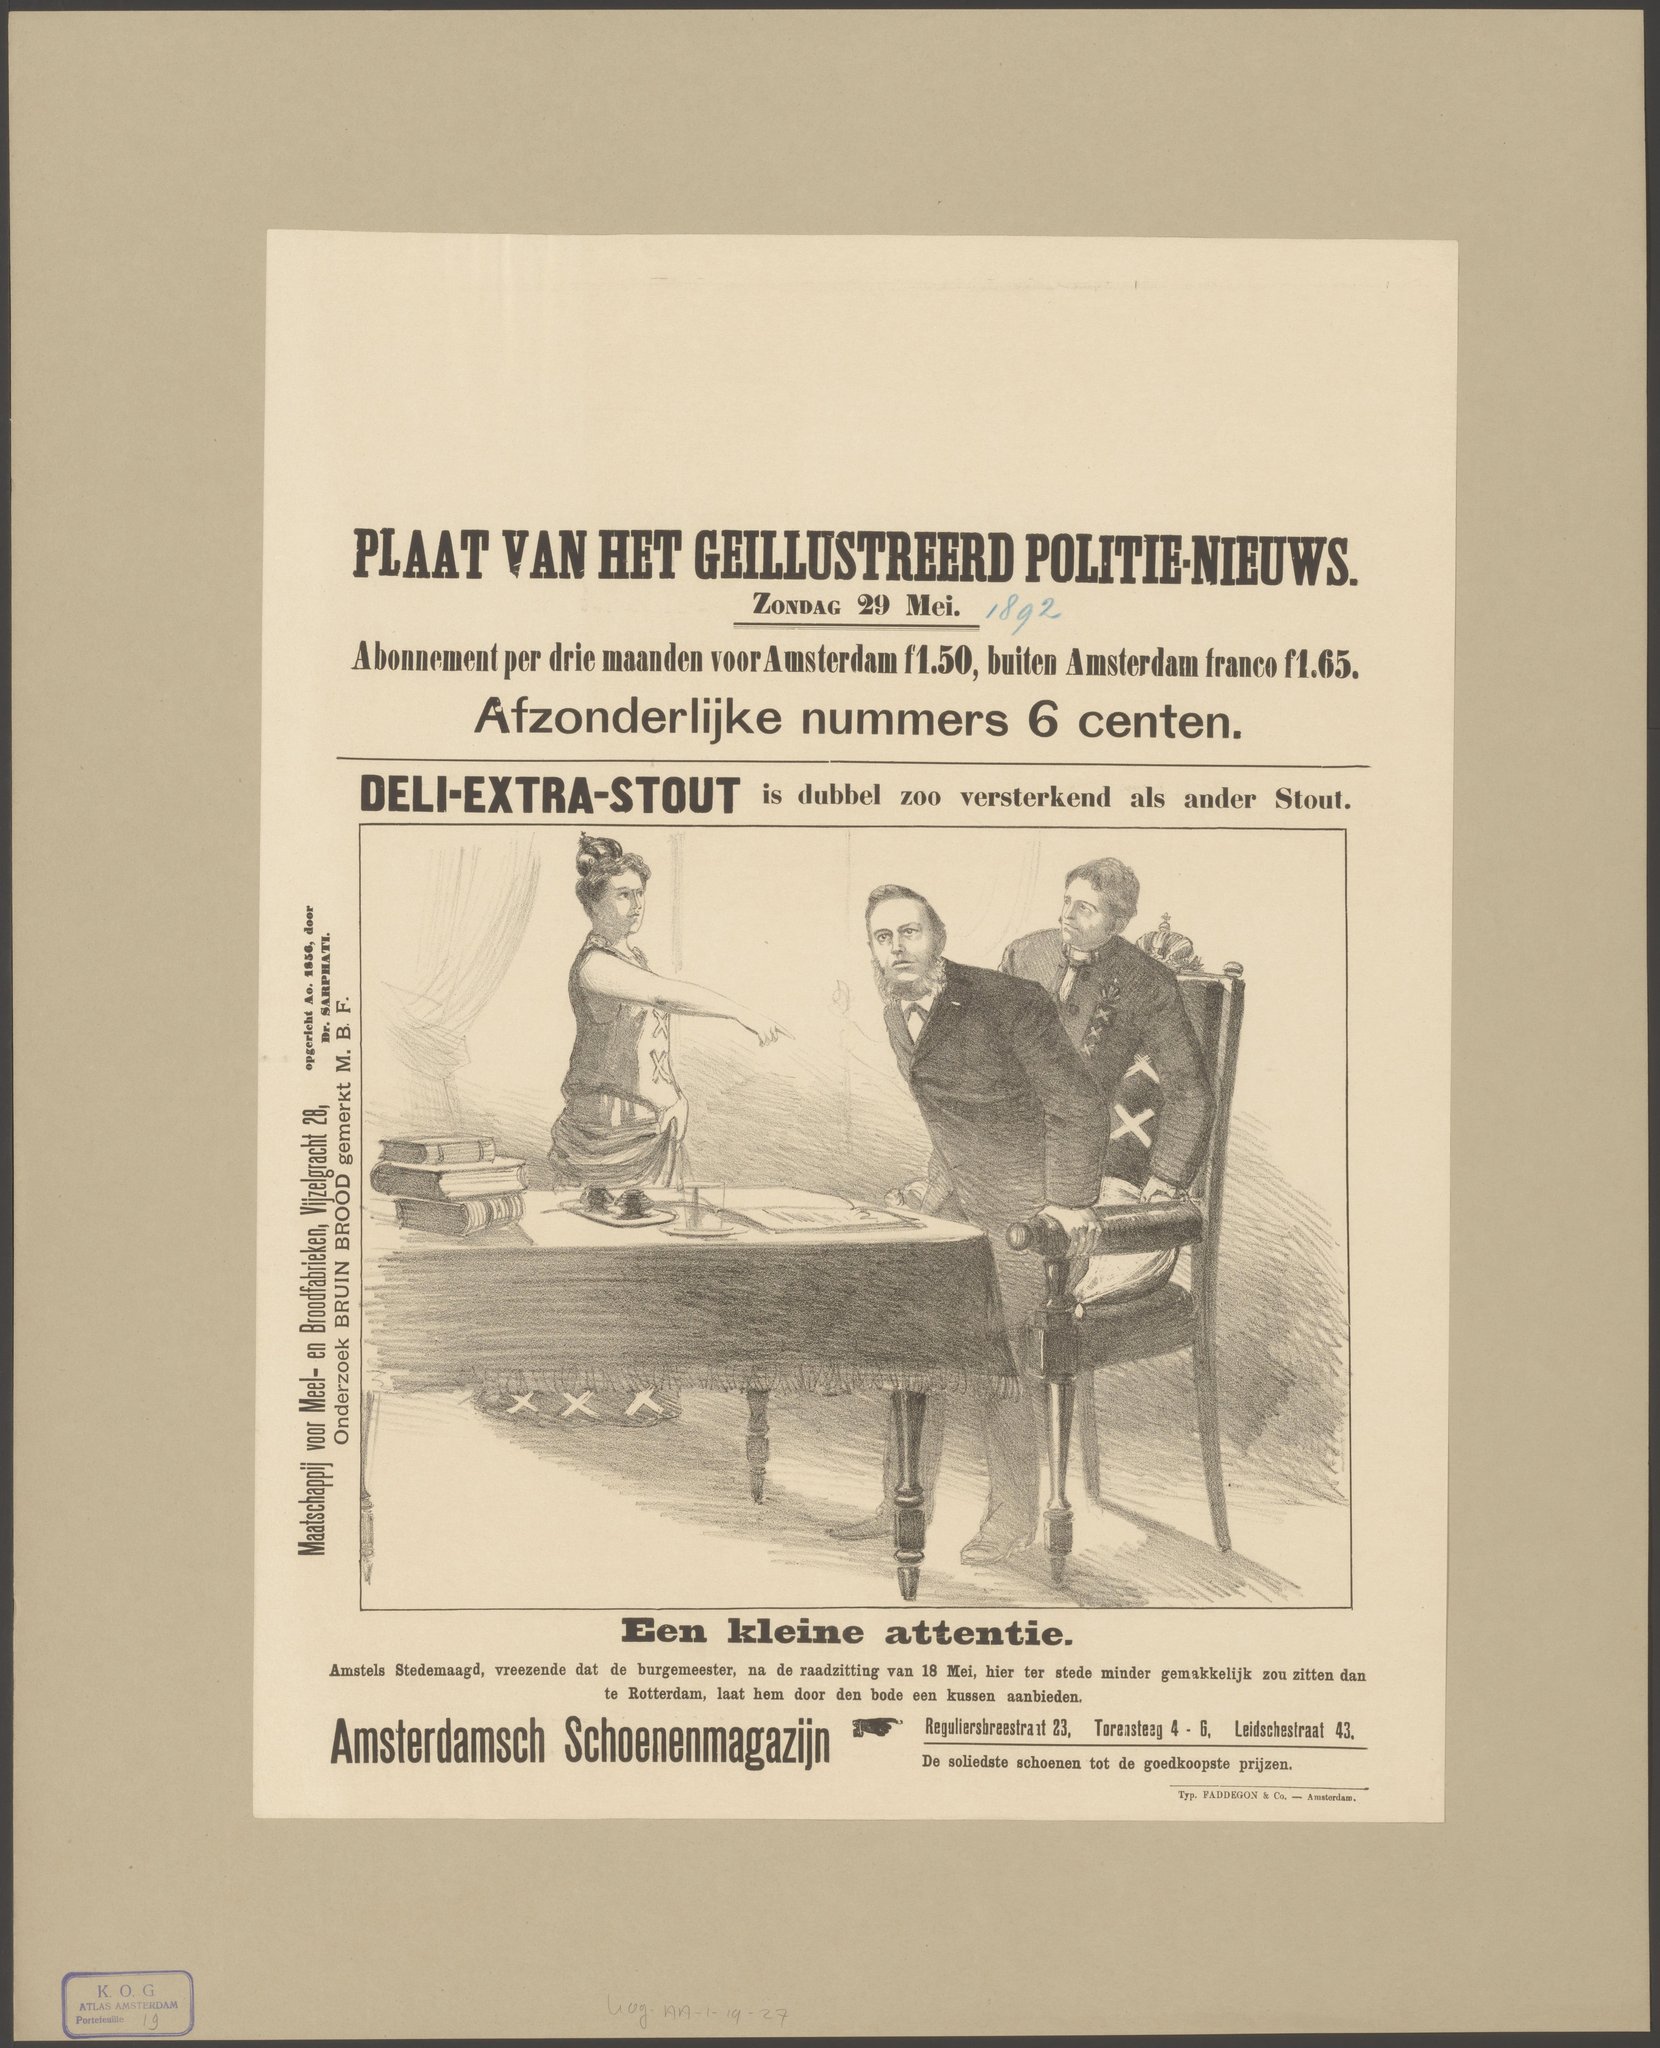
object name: cartoon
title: Spotprent op de installatie van Sjoerd Anne Vening Meinesz als burgemeester van Amsterdam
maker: johan braakensiek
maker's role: draughtsman, print maker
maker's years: 1858-1940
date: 1892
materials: paper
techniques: letterpress printing, lithograph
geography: amsterdam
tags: mayor, burgomaster, installation of a ruler, amsterdam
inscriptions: collector's mark: ‘19’ Lugt 1641b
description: Onderwerpsrubriek binnen de Atlas Amsterdam: Herinneringen aan regeringsleden en hunne huisgezinnen [na 1800].